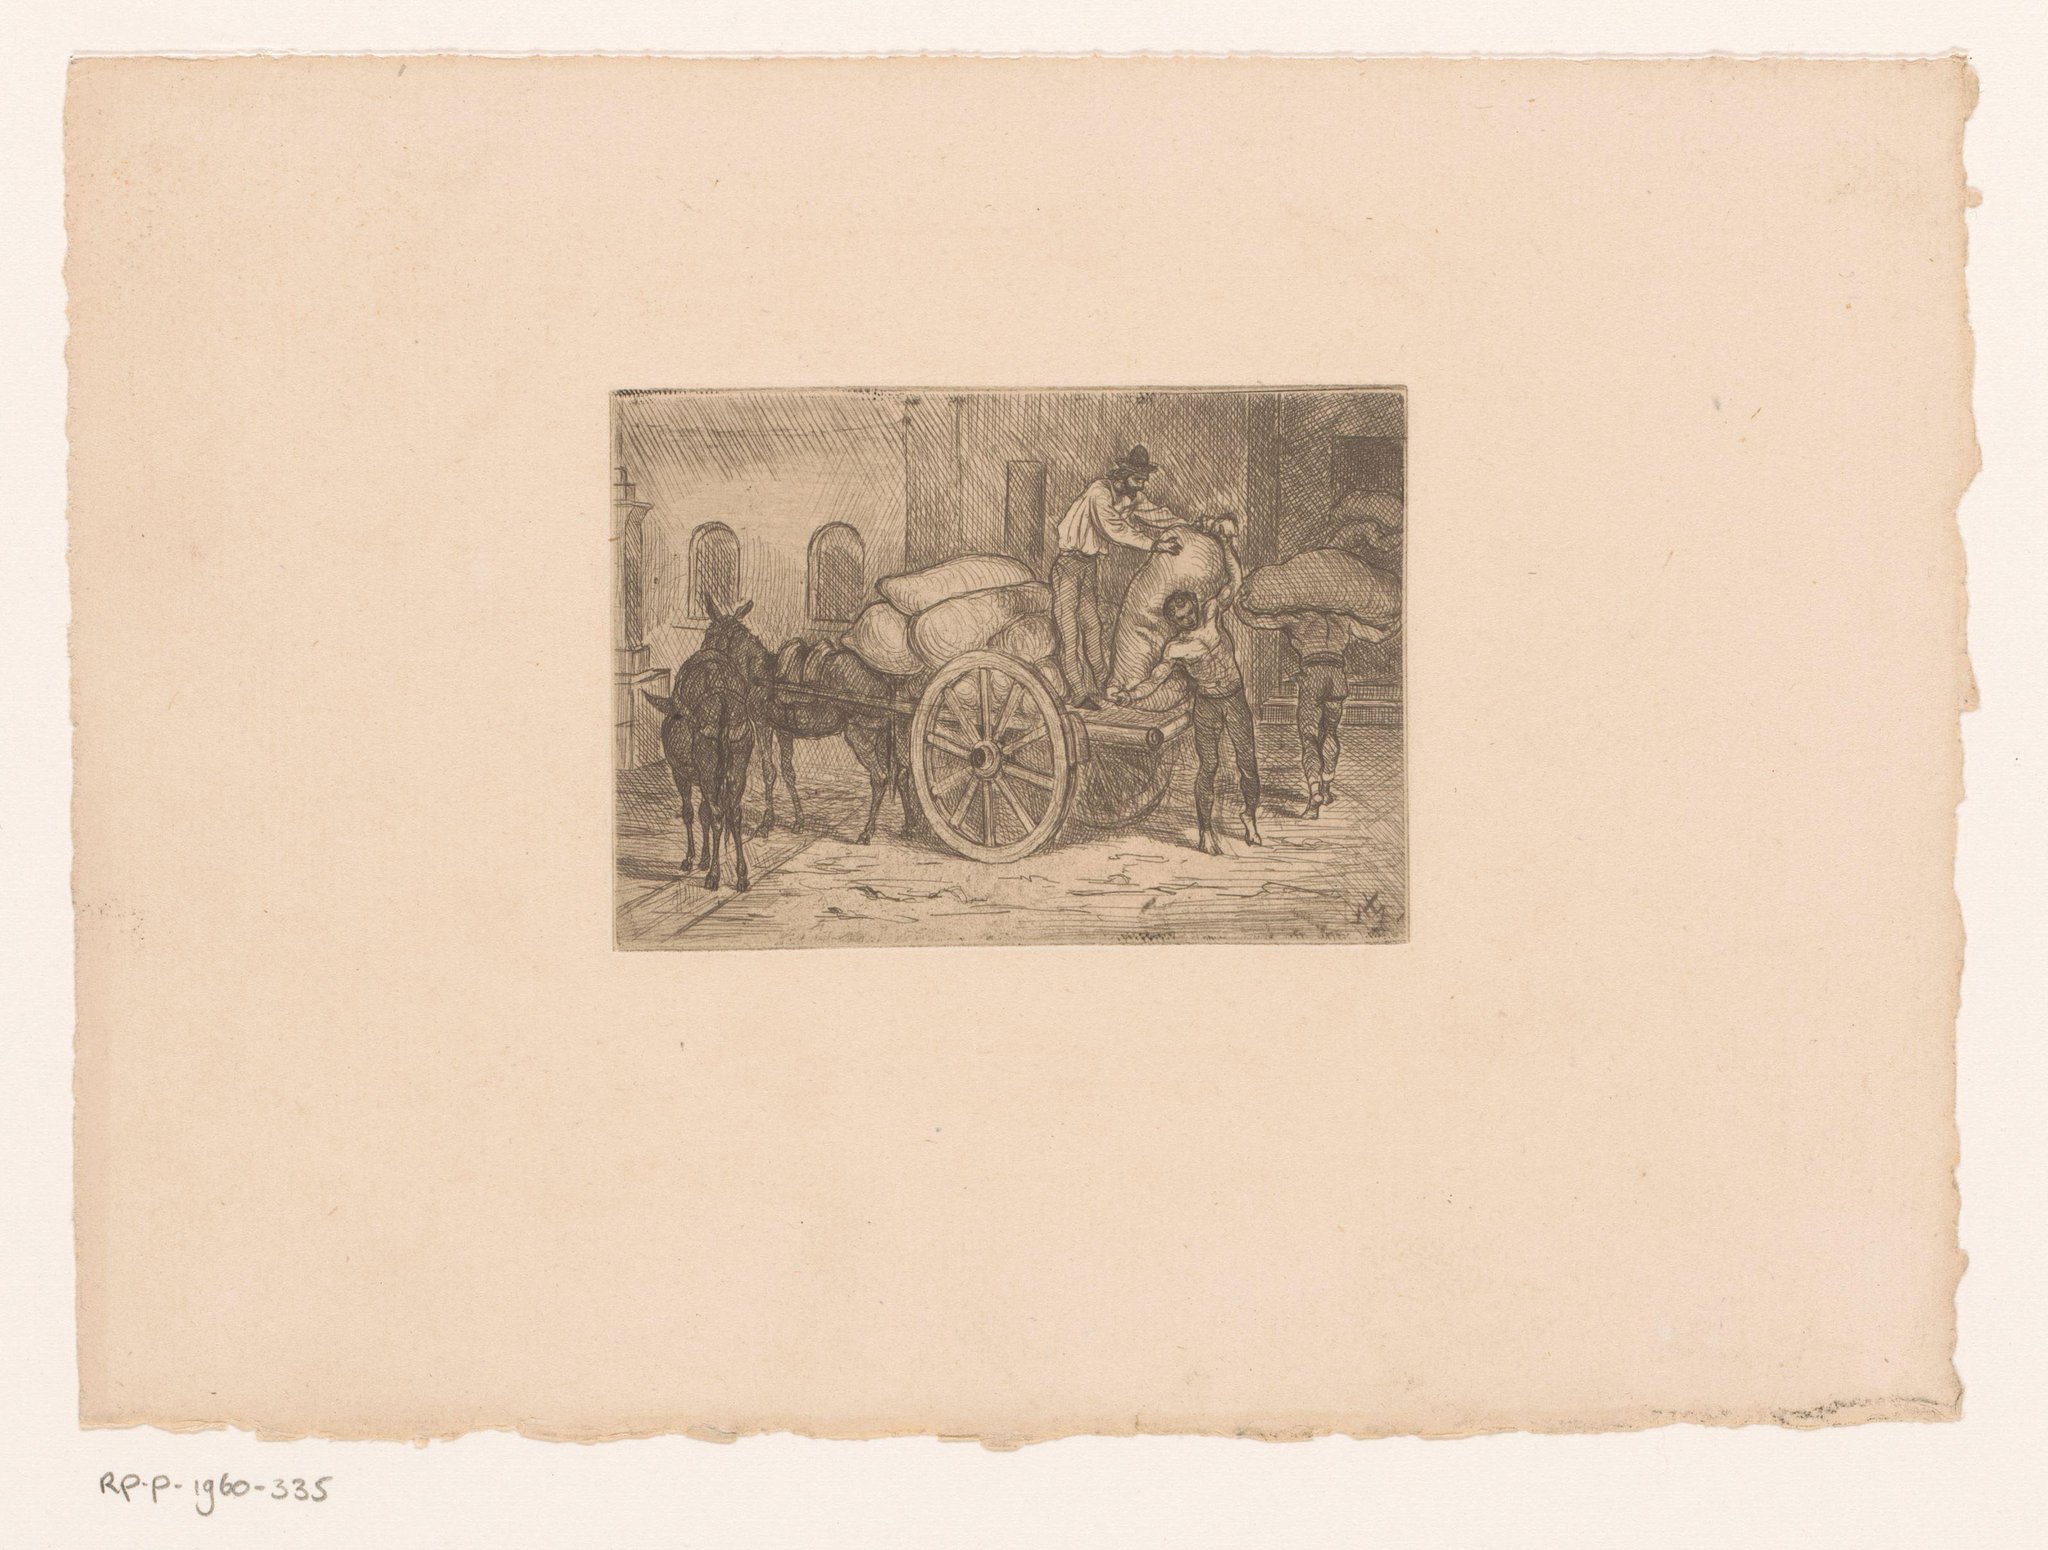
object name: print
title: Mannen laden zakken af van een wagen getrokken door muildieren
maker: xavier mellery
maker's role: print maker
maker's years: 1845-1921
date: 1855-1913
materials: paper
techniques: etching, intaglio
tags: container of textile material: bag, sack, two-wheeled vehicle drawn by two animals, mule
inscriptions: collector's mark: Lugt 2228